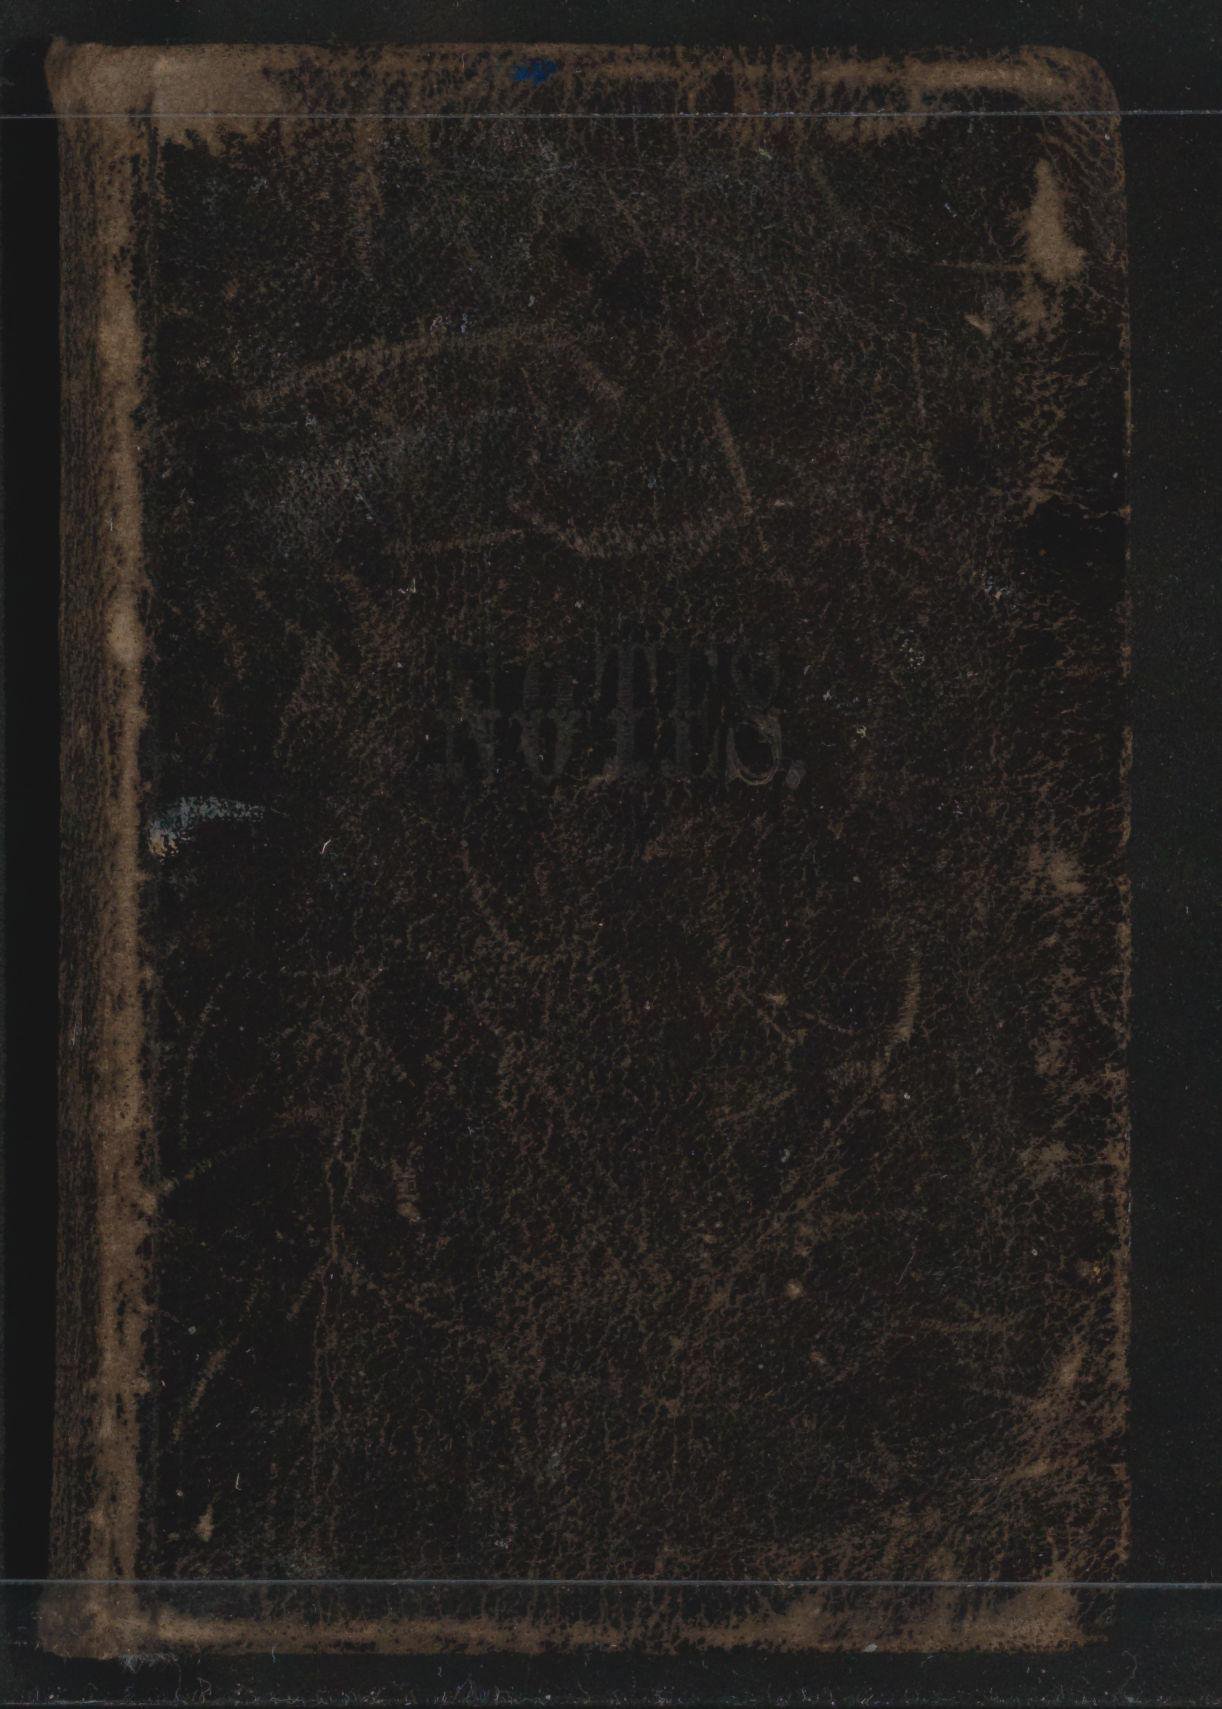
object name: sketchbook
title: Schetsboek met 110 bladen betekend tijdens de expeditie naar Nova Zembla in 1880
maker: louis apol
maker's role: draughtsman, painter, print maker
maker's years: 1850-1936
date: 1880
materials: leather, pencil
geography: barentsz sea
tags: iceberg, sea (seascape), drift ice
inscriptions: collector's mark: Lugt 2228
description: Getekend aan boord van het schip 'Willem Barentsz.'.